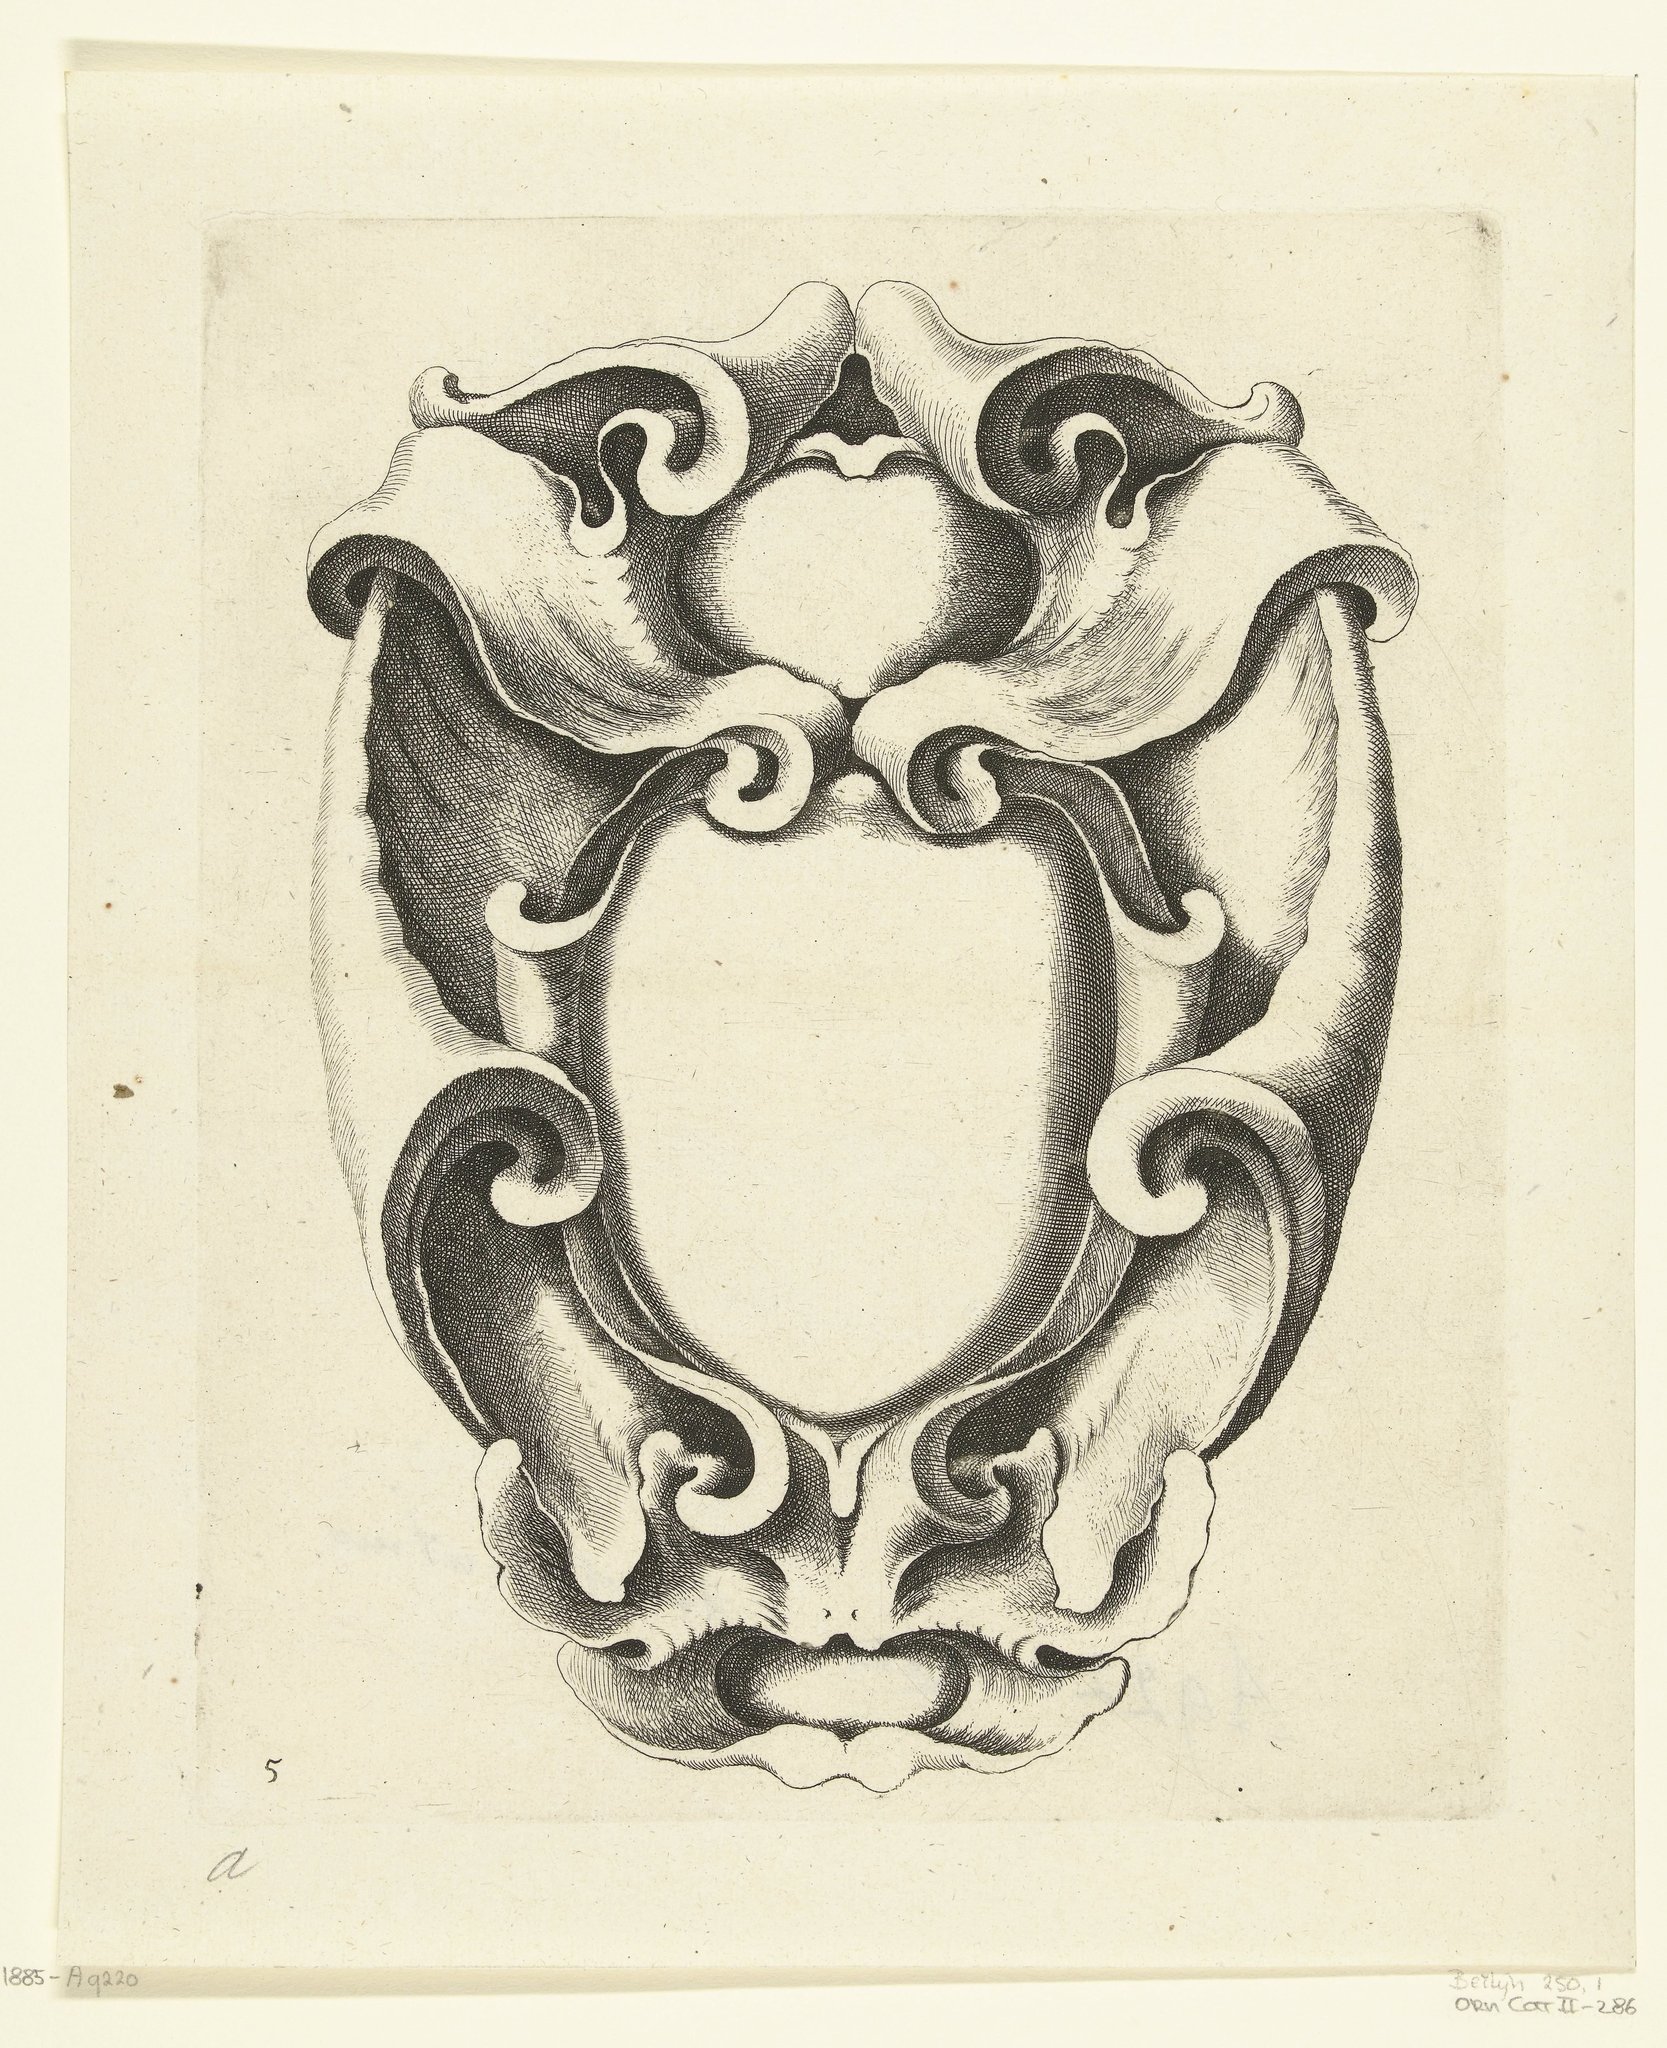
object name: print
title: Veelderhande Nieuwe Compartemente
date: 1654-1678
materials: paper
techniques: etching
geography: amsterdam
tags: ornament ~ cartouche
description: Het middelste compartiment is groot, de andere twee zijn klein.